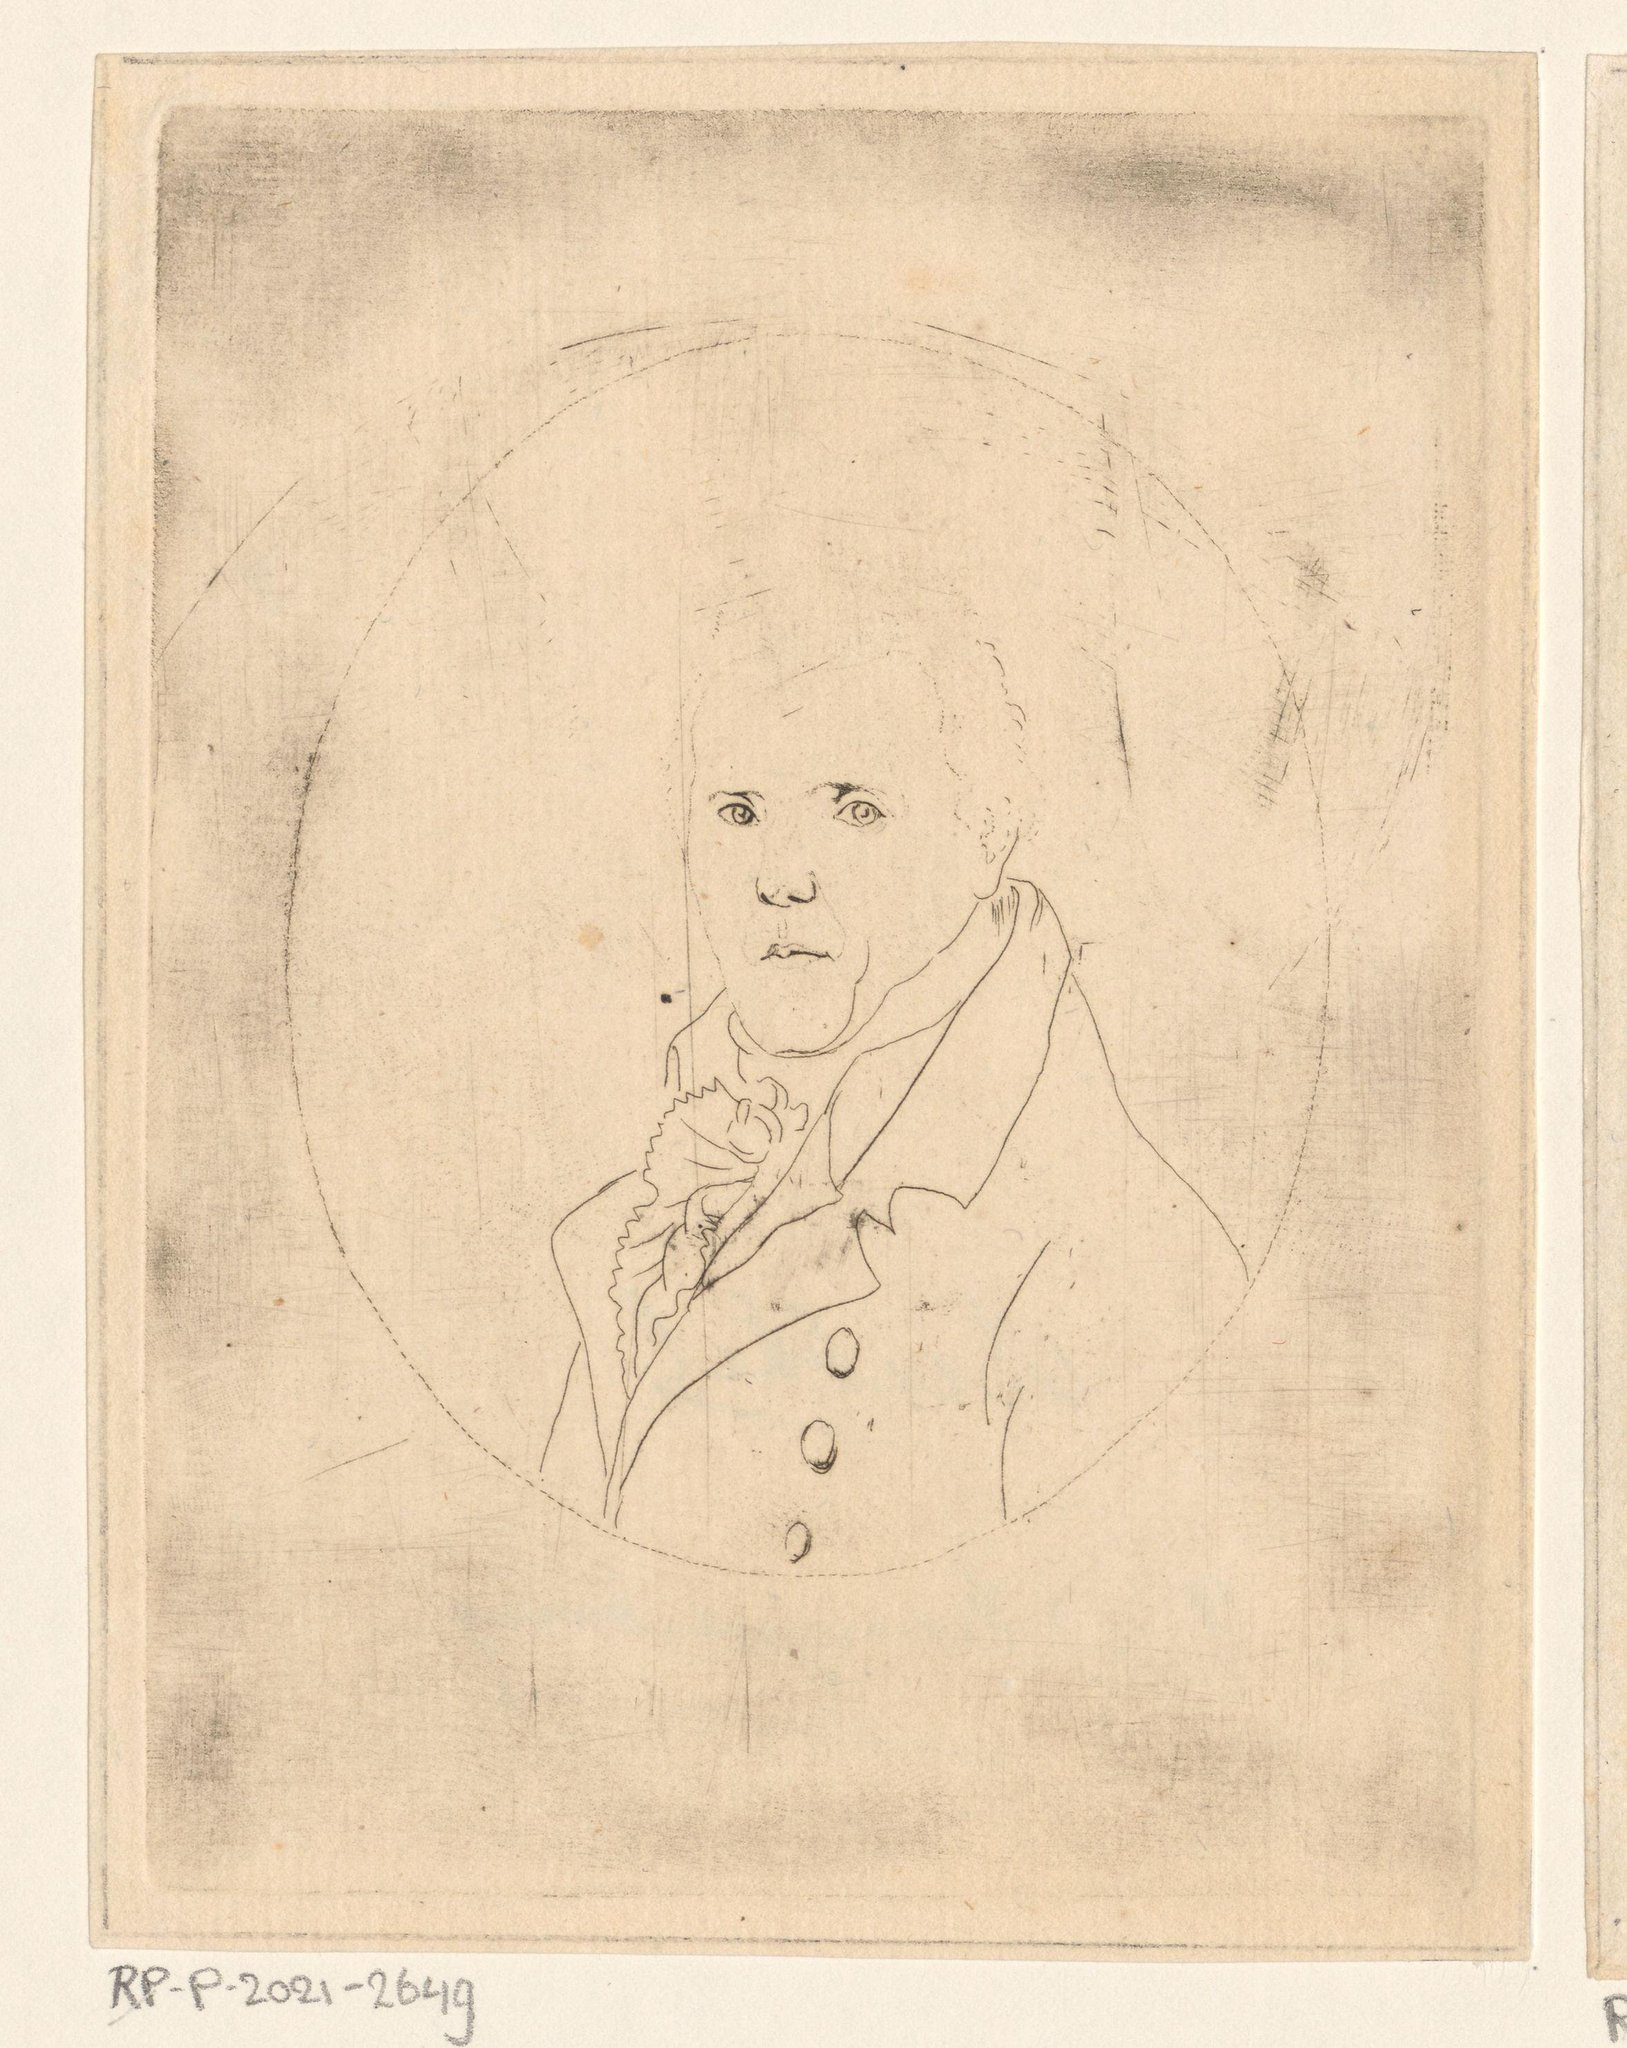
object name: print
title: Portret van Jan Konijnenburg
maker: anthonie van den bos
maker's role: draughtsman, print maker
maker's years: 1763-1838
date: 1773-1838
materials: paper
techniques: etching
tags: leiden, amsterdam, jan konijnenburg, historical persons